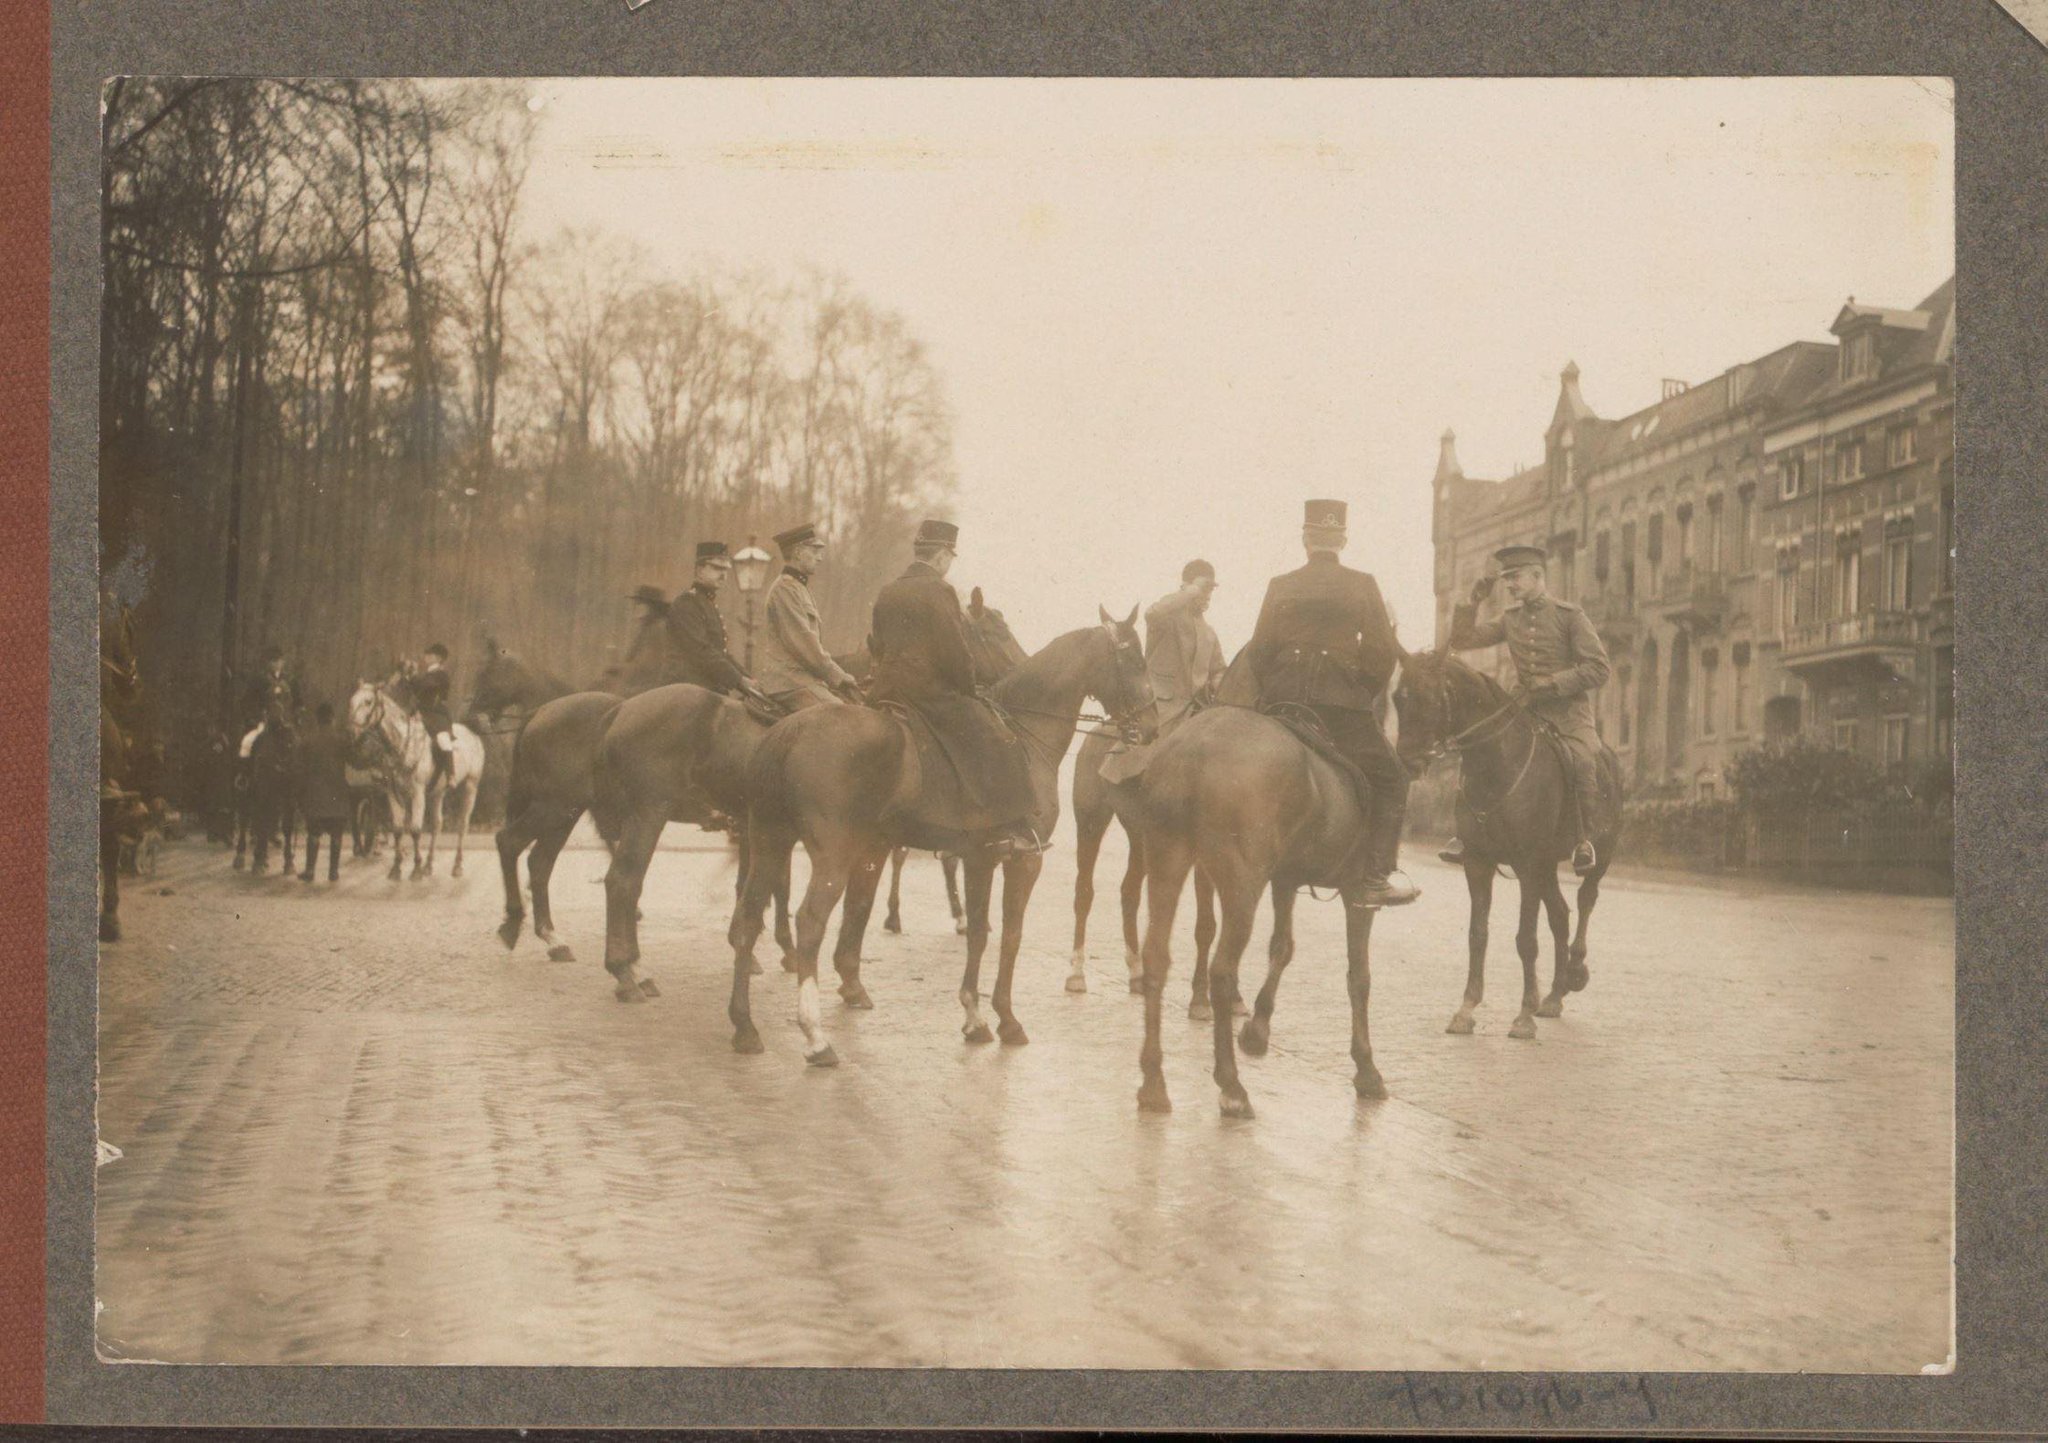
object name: photograph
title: Ruitertafereel op Koninklijke Houtvesterij Het Loo: ruiters op een plein voor een gebouw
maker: Anonymous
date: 1900-1925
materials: photographic support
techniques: gelatin silver print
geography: het loo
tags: riding a horse, ass, or mule; rider, horseman, hunting, chase, hunting-ground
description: Onderdeel van Fotoalbum van de heer Brams, opperhoutvester van koningin Wilhelmina op Koninklijke Houtvesterij Het Loo.